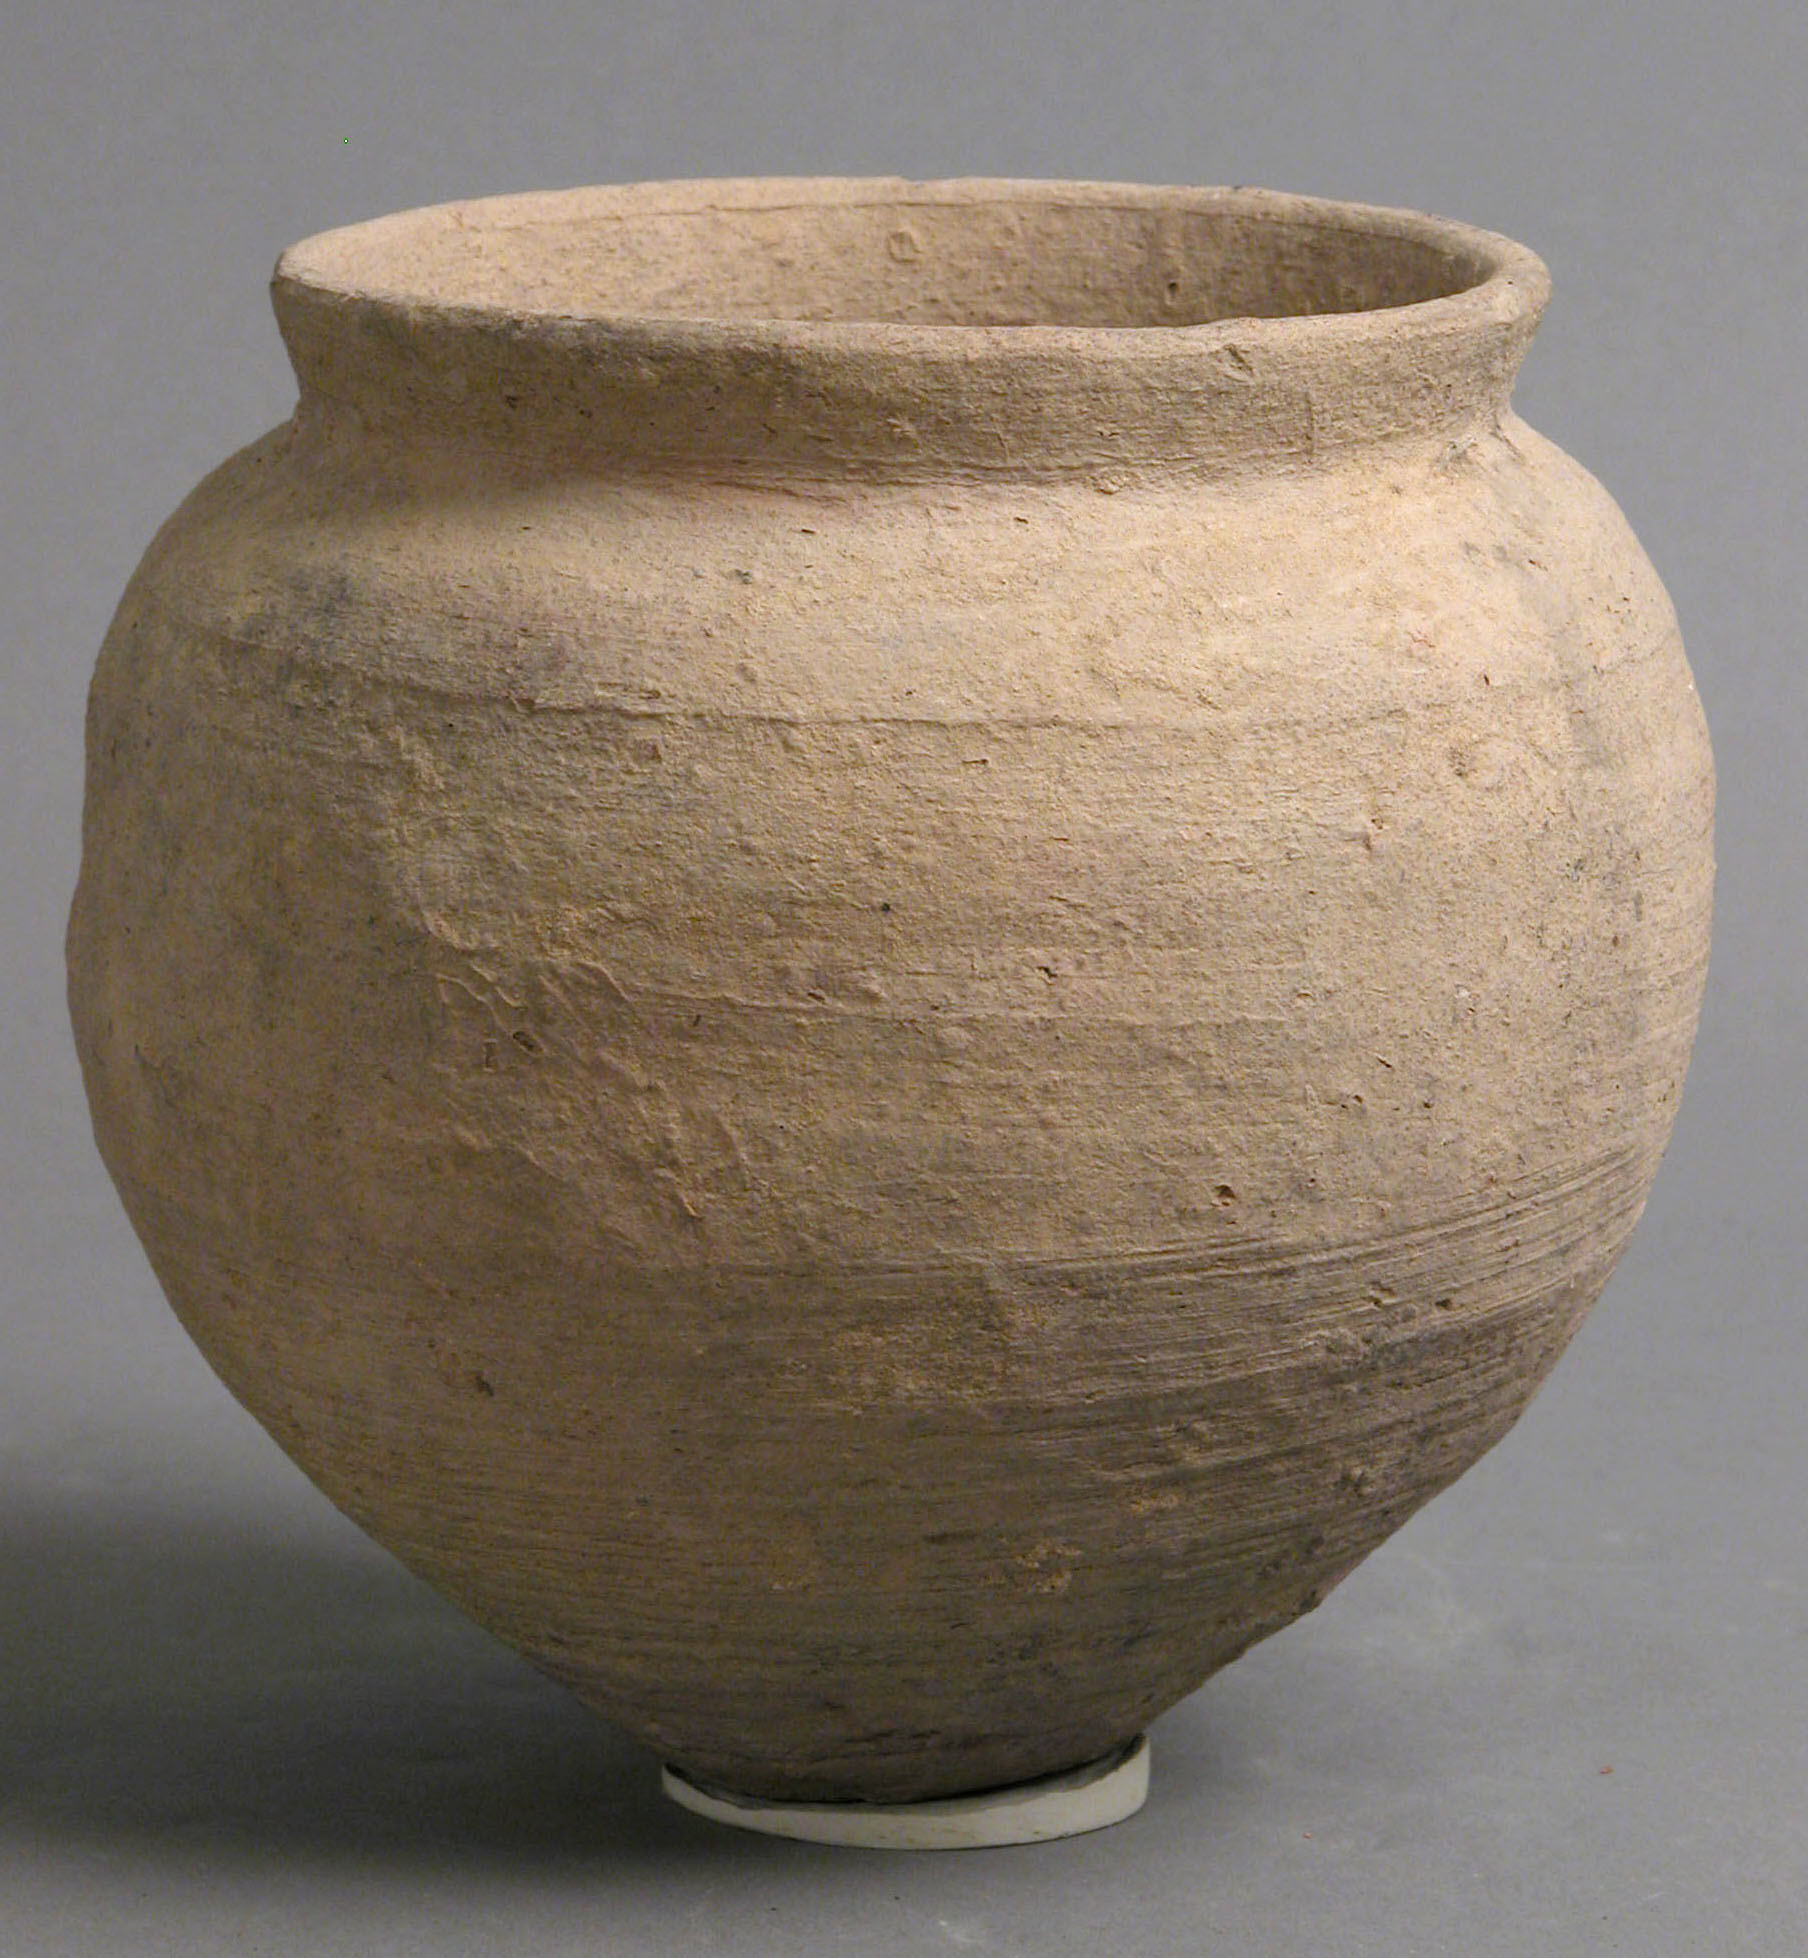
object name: pot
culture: coptic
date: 301-700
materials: earthenware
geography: egypt